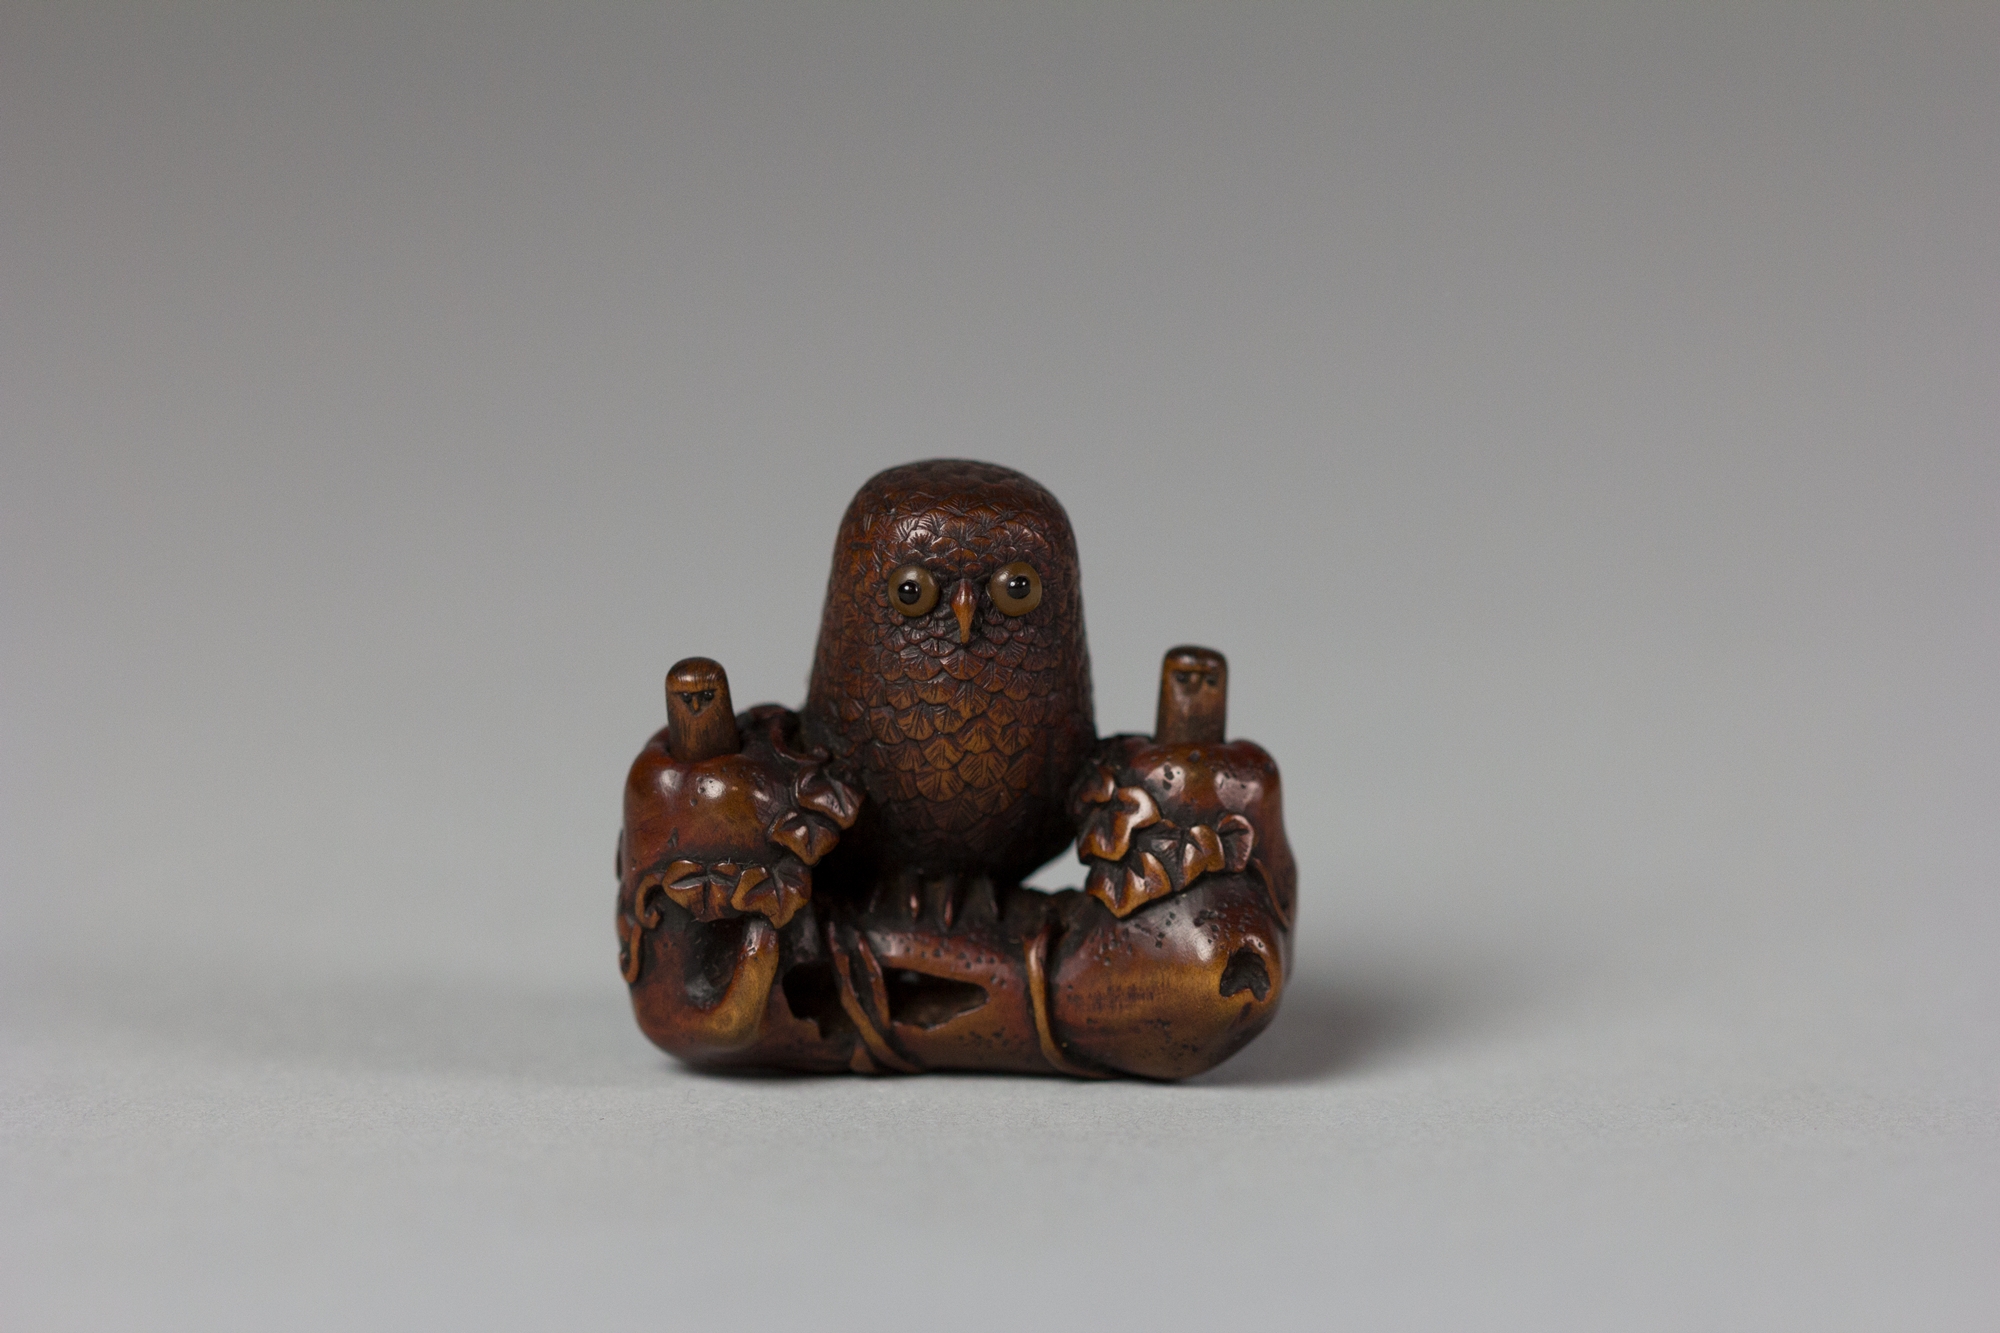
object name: netsuke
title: Netsuke of Owl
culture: japanese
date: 1801-1900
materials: wood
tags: owls